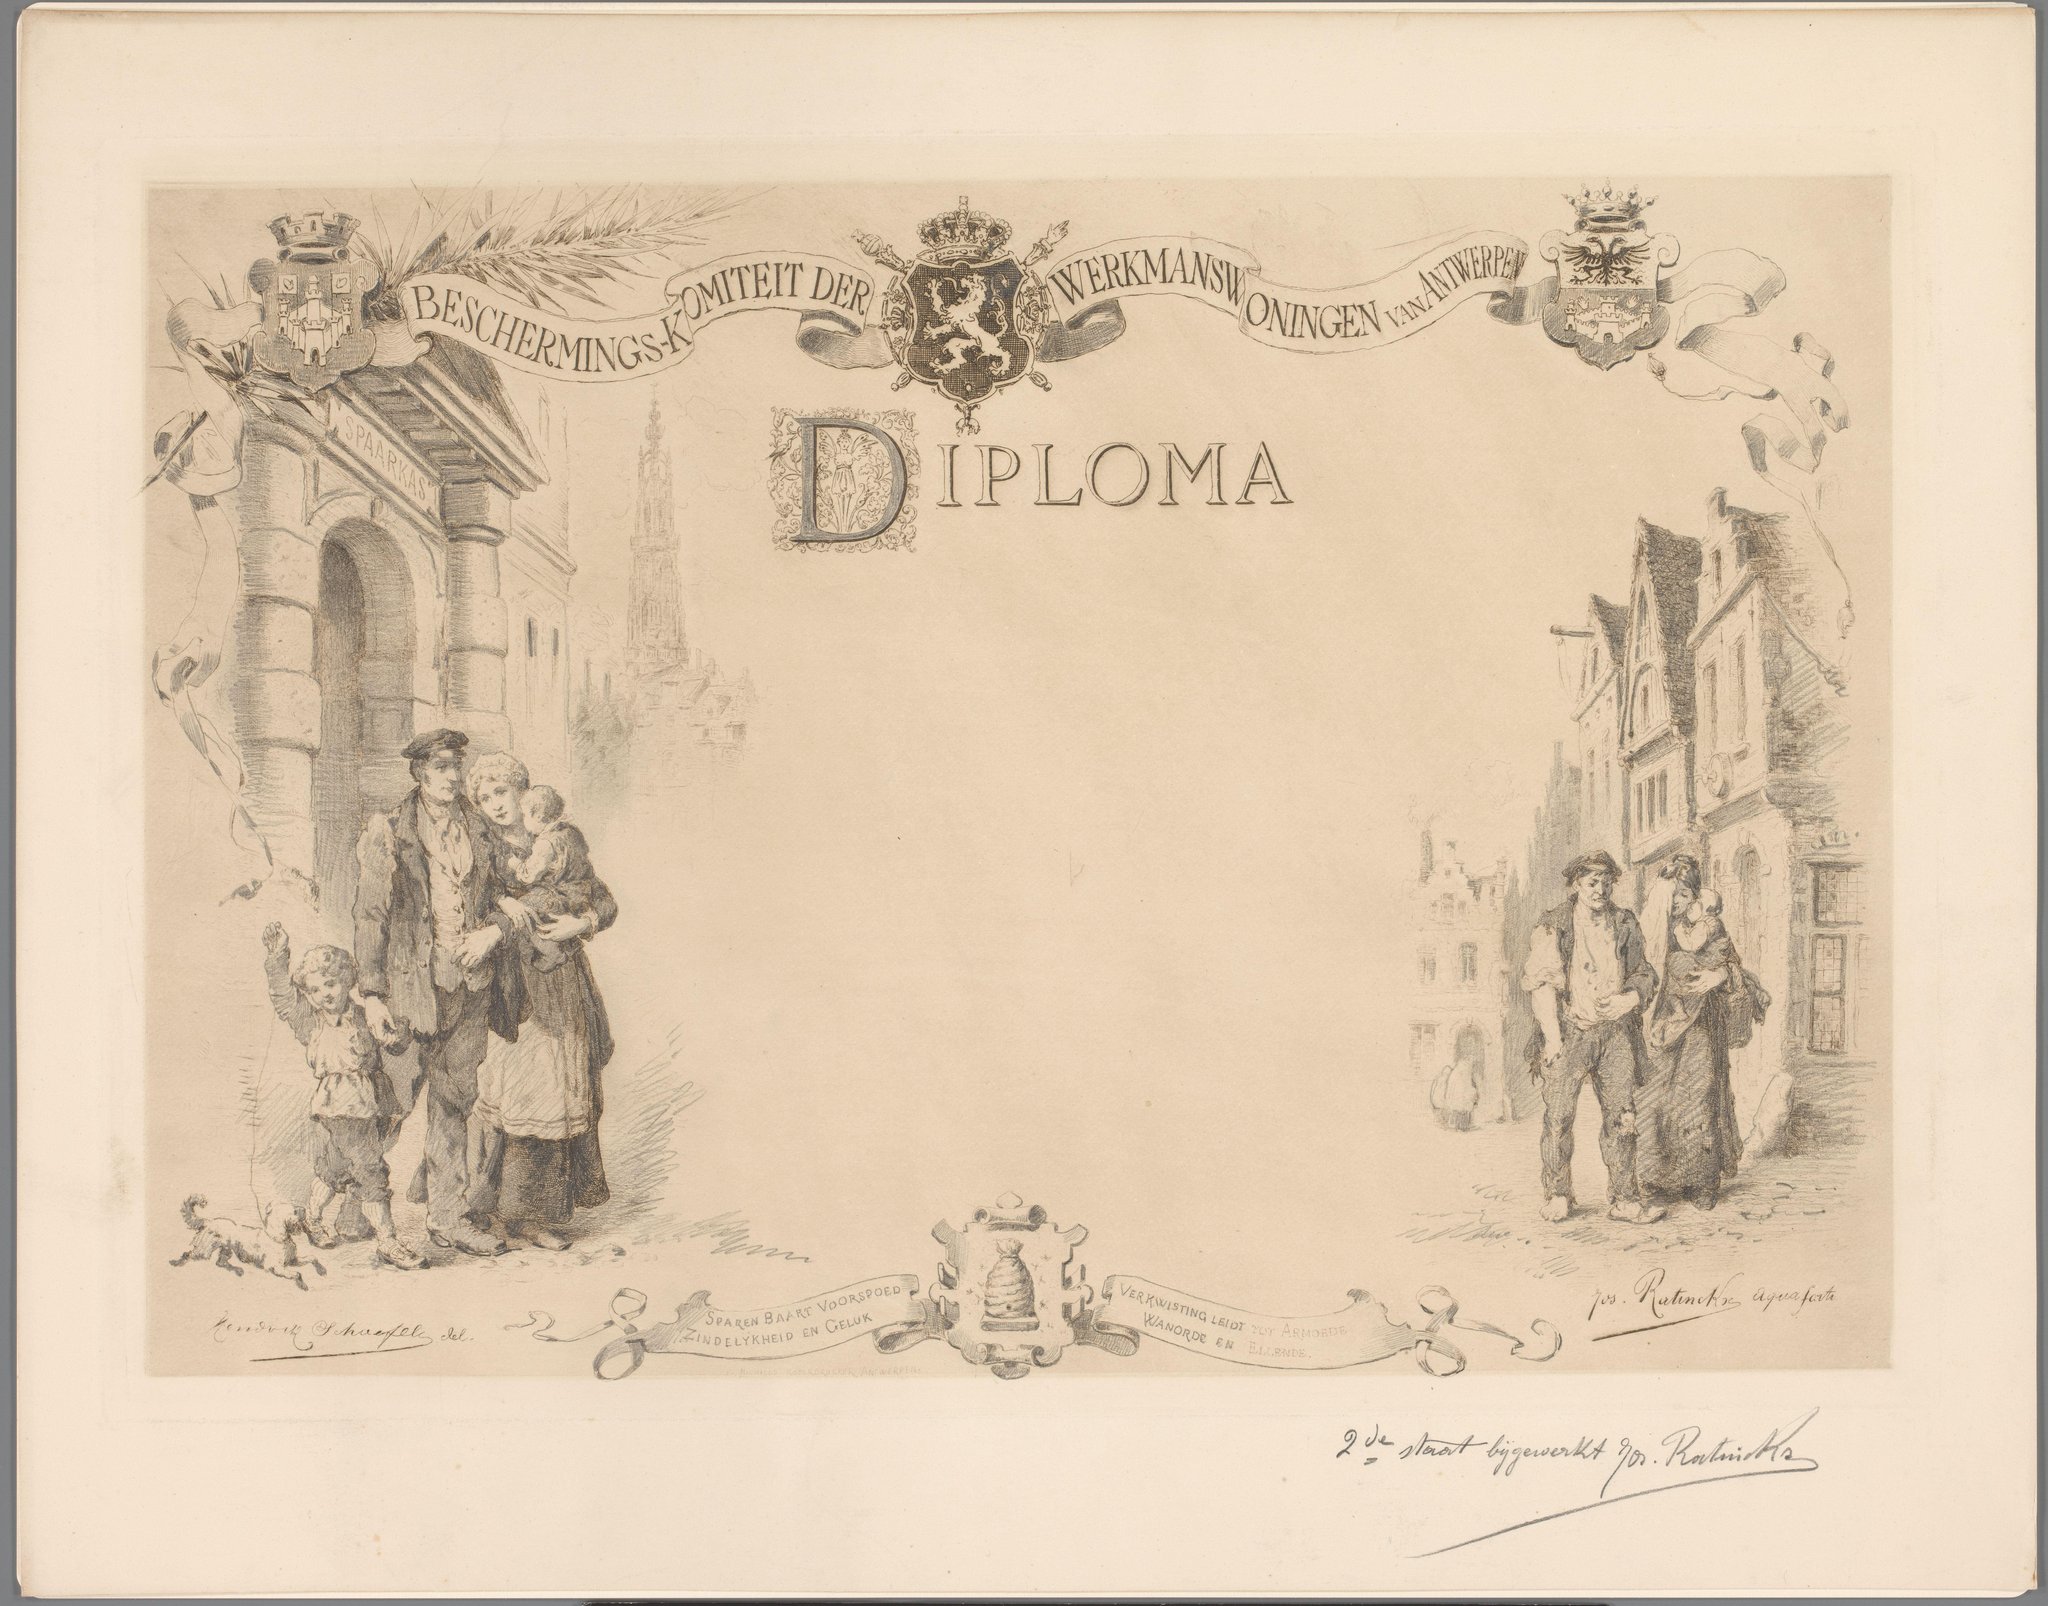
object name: print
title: Beschermings-komiteit der werkmanswoningen van Antwerpen; diploma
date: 1870-1914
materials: paper, pencil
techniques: etching, intaglio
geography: antwerp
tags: working class, labourers, street, the poor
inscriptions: inscription: ‘2de staat bijgewerkt’, collector's mark: Lugt 2228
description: De voorstelling verwijst naar de voordelen van sparen. De familie links bij de spaarkas heeft het goed, terwijl de familie rechts in armoede leeft. Onder een latere staat van deze prent staat het onderschrift: Sparen baart voorspoed zindelykheid en geluk; verkwisting leidt tot armoede wanorde en ellende.